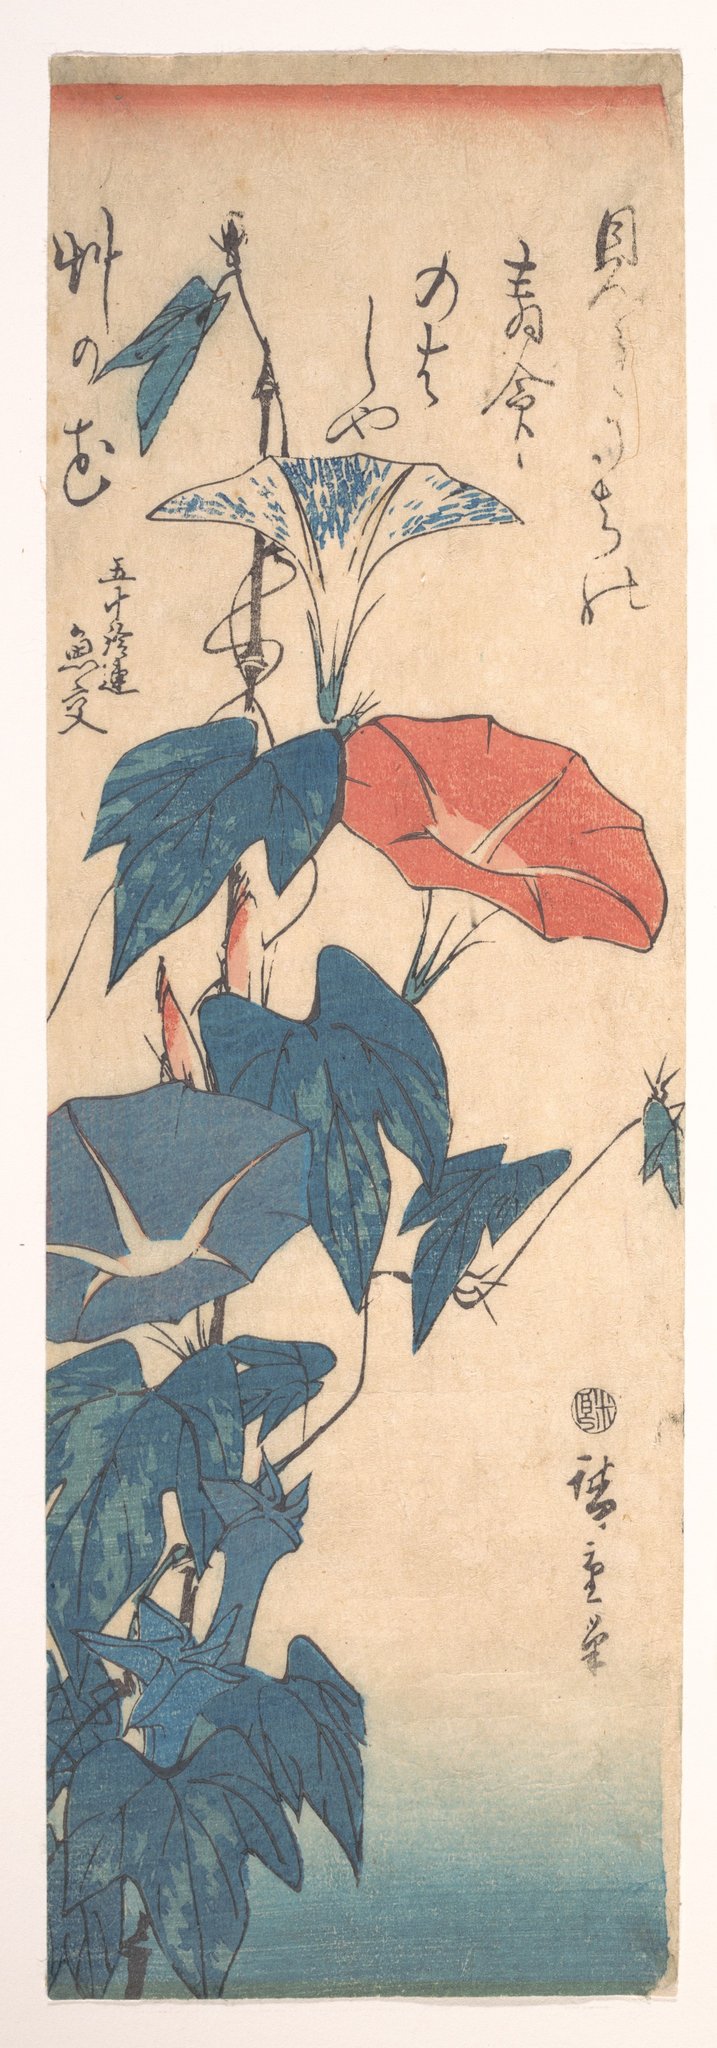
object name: print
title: Morning Glories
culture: japanese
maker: utagawa hiroshige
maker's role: artist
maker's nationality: japanese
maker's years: 1797-1858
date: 1847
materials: ink, paper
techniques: woodblock print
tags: flowers